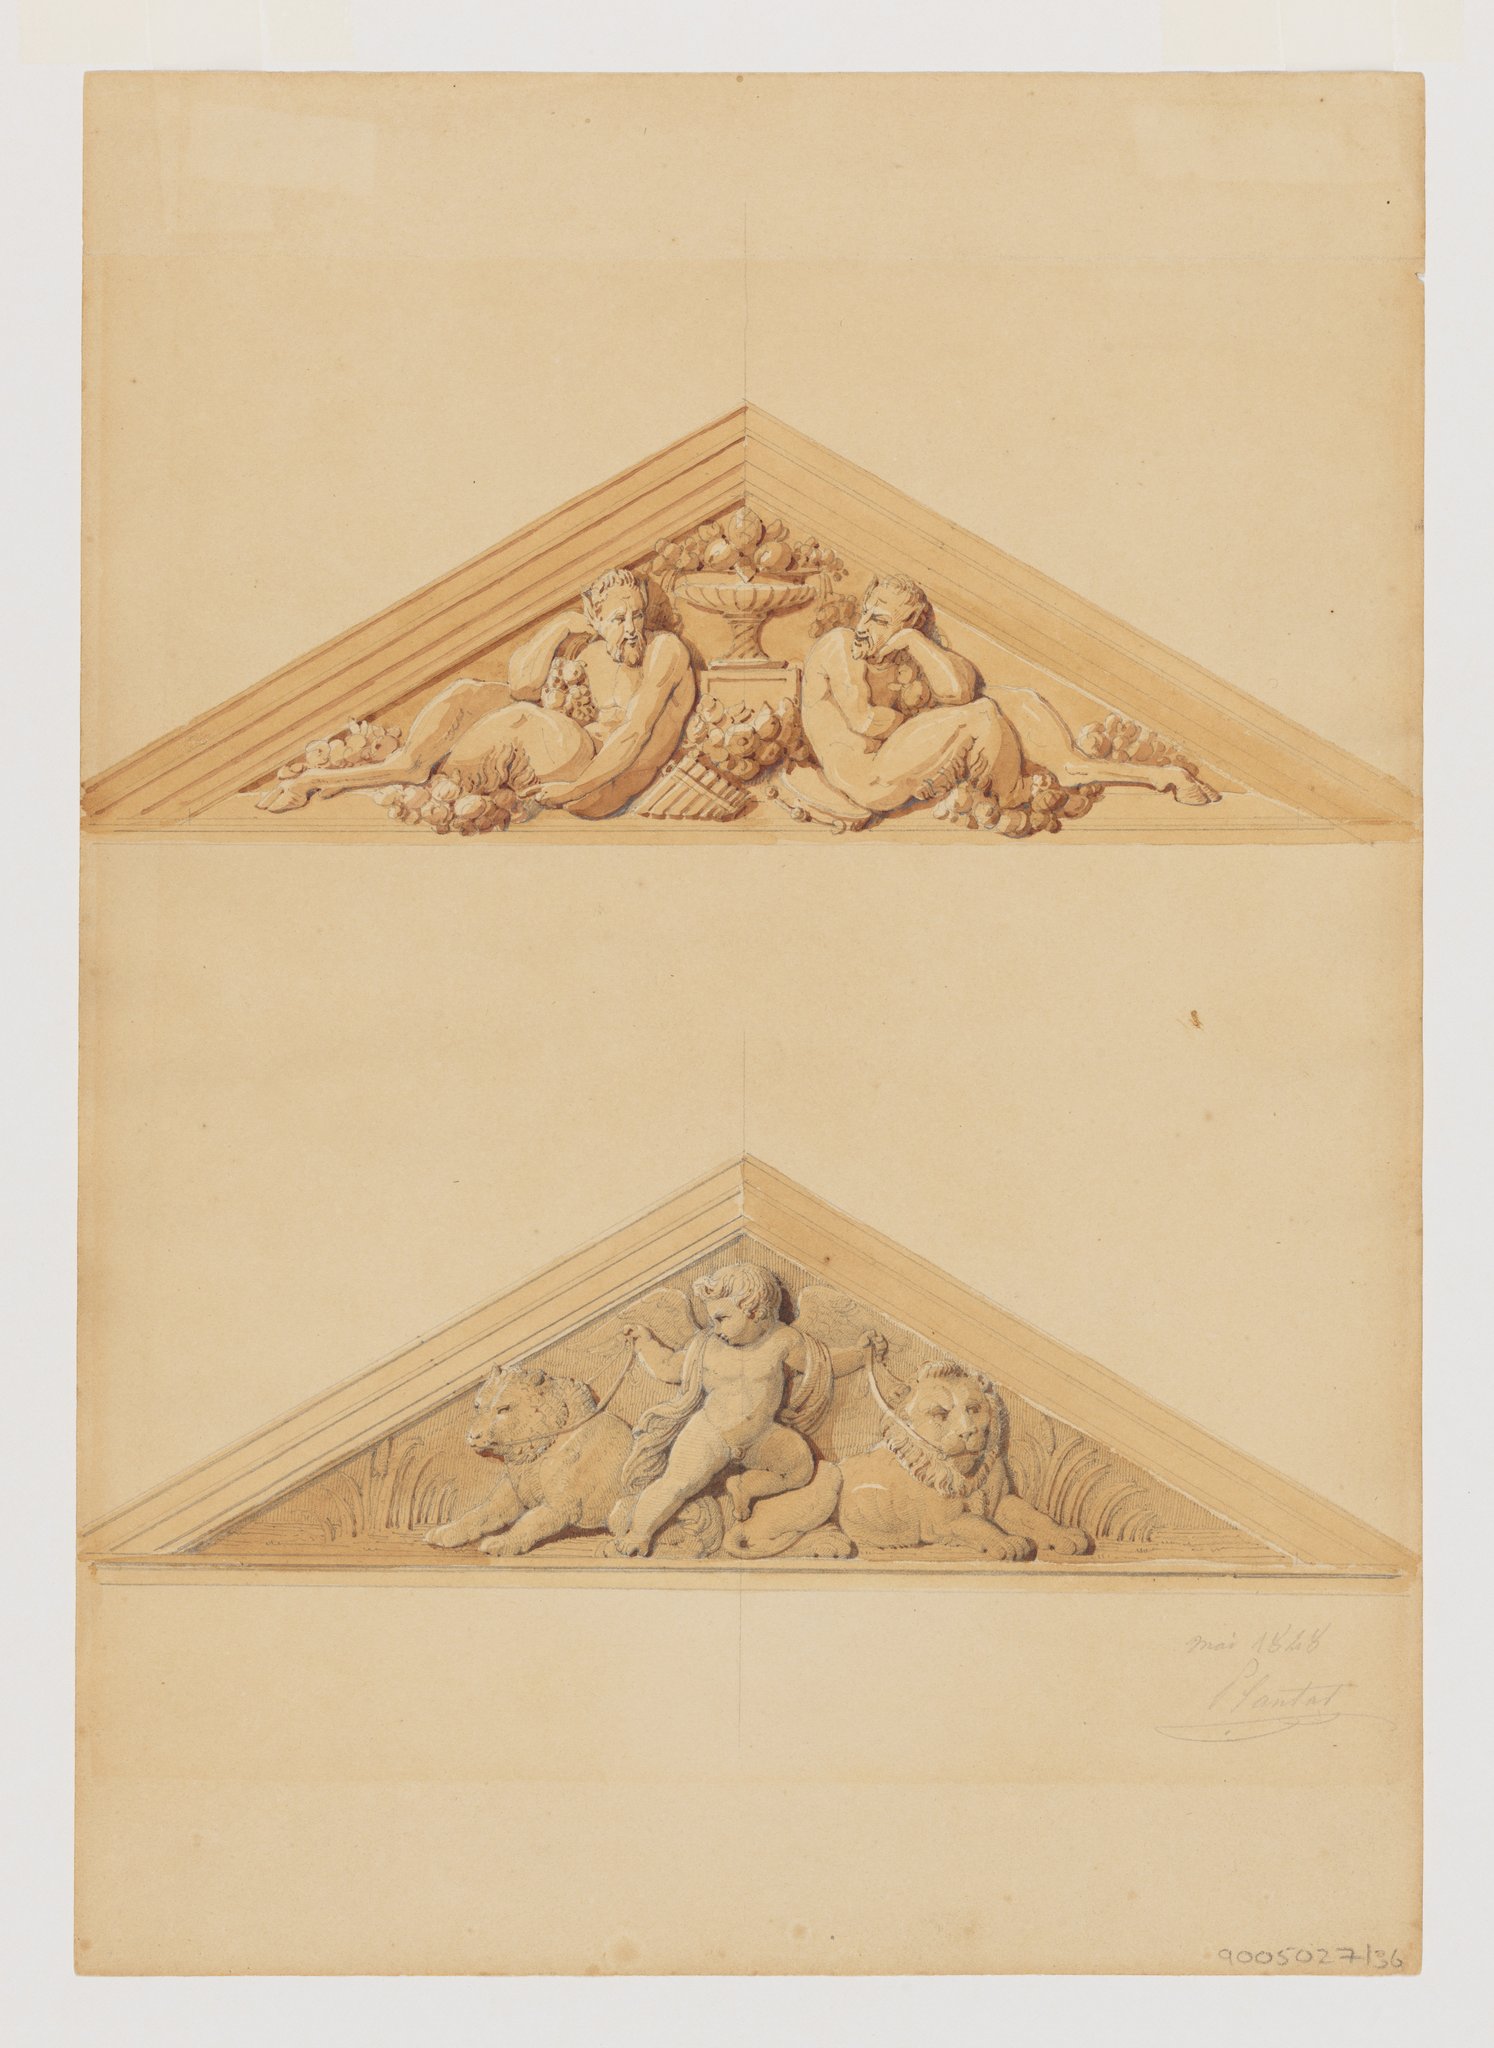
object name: drawing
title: Two Designs for Pediments, one with Satyrs, one with a Putto and Two Lions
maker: jean-baptiste louis plantar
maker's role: artist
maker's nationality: french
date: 1834-1866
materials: graphite, ink, watercolor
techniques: pen